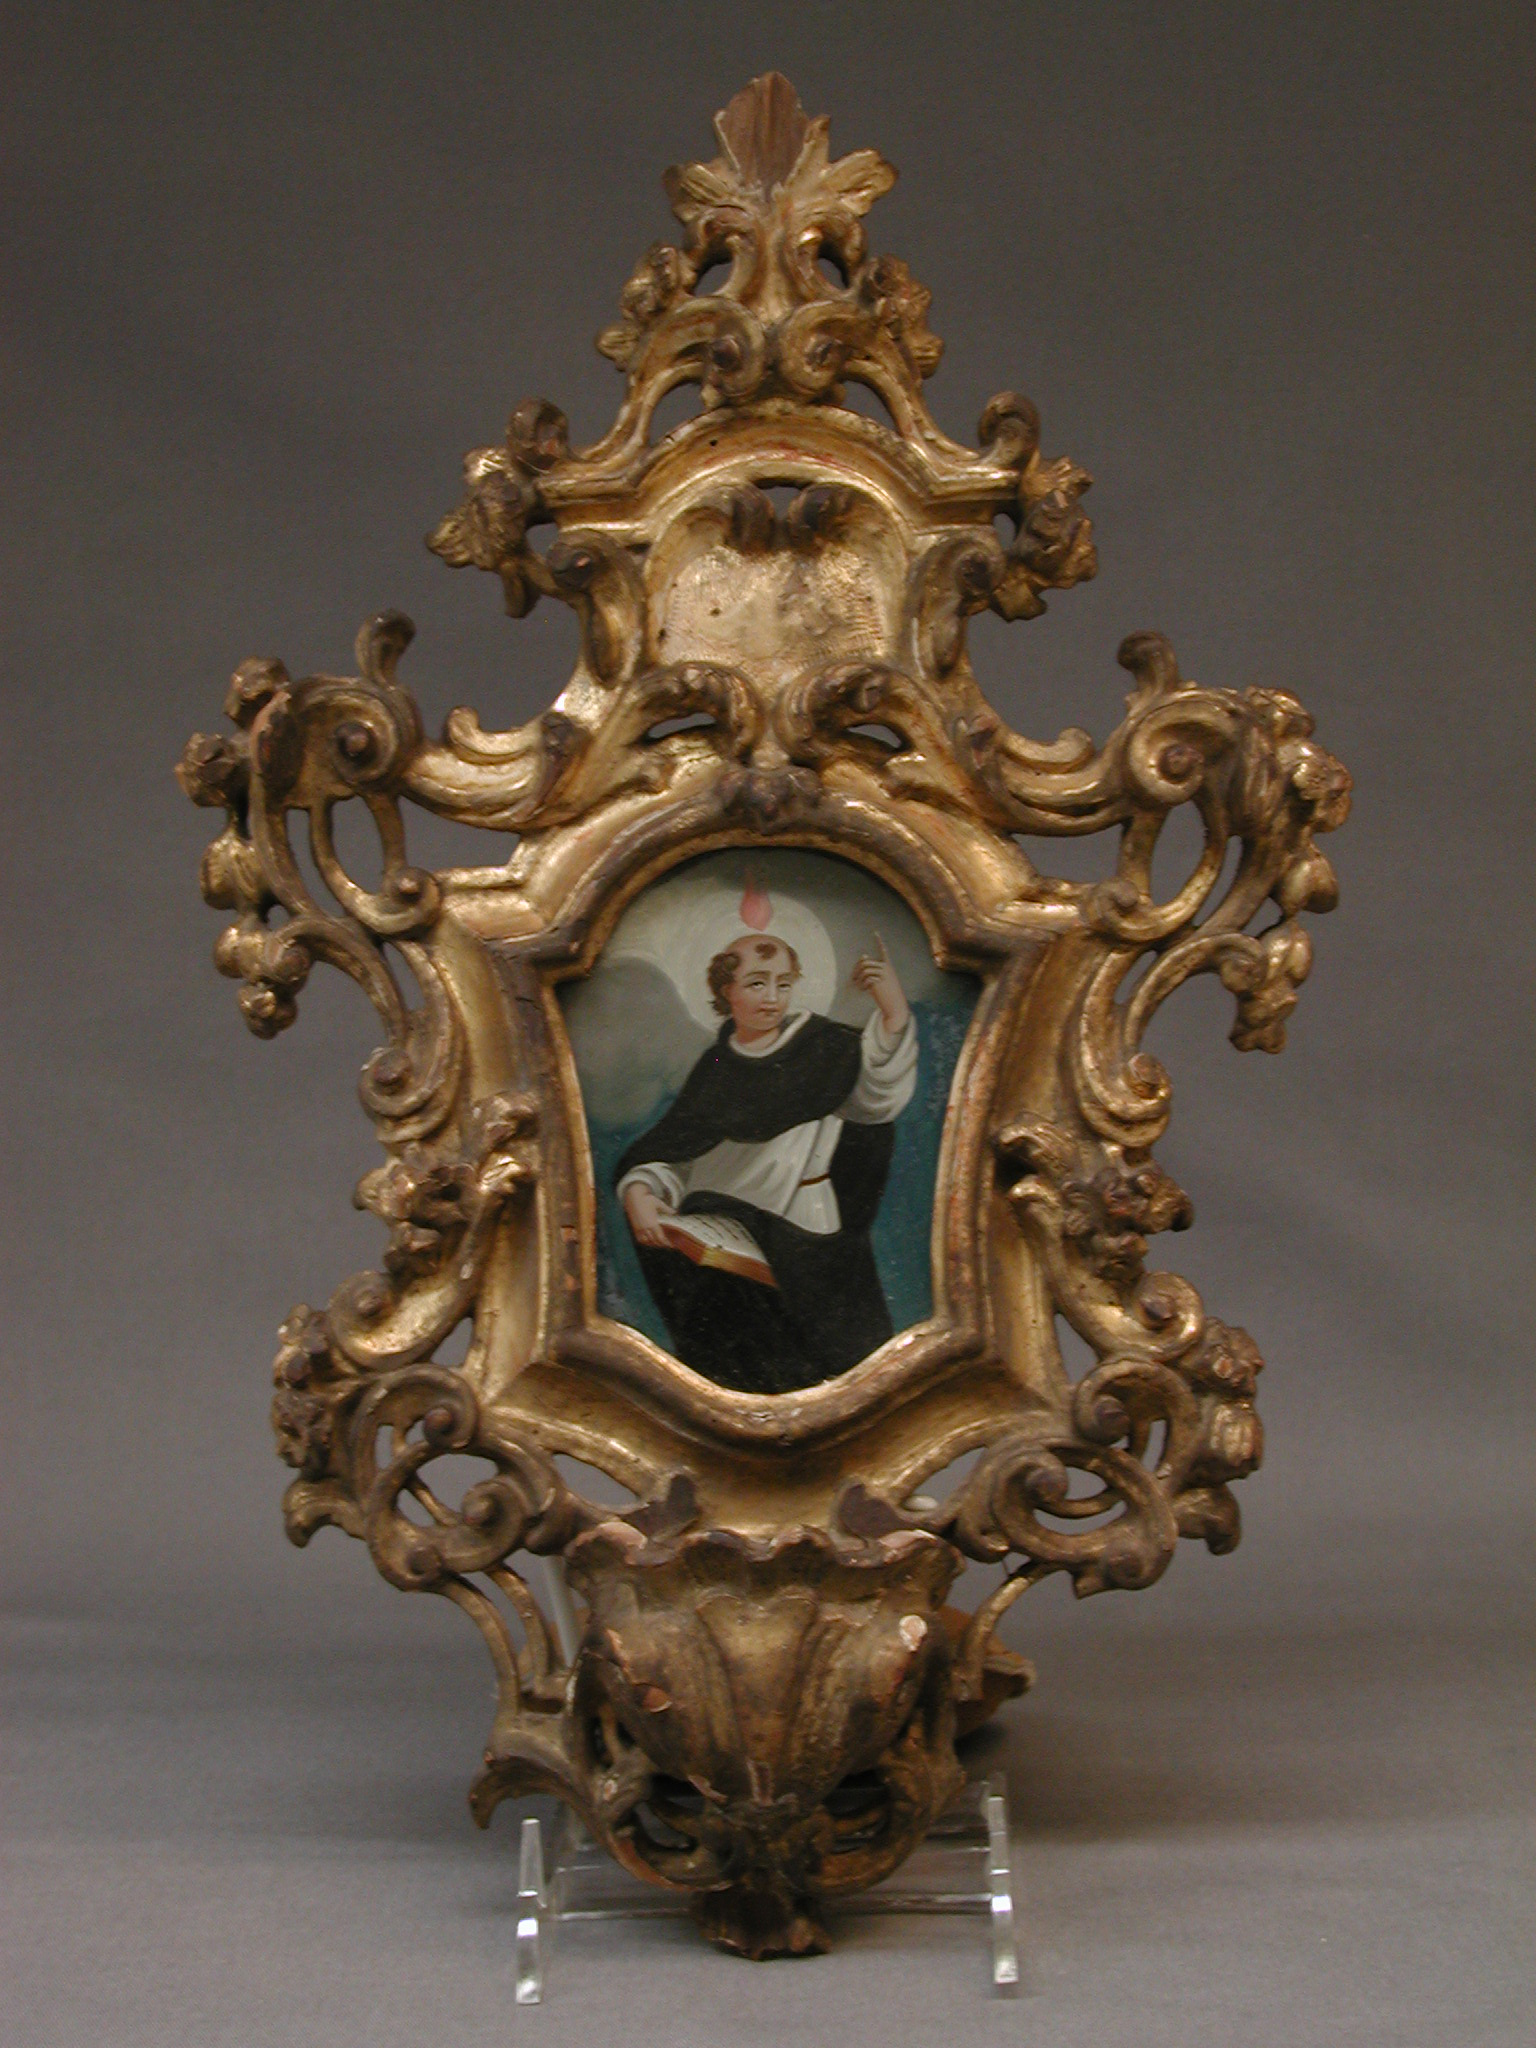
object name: bénitier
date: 1667-1800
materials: glass, wood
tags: men,saints